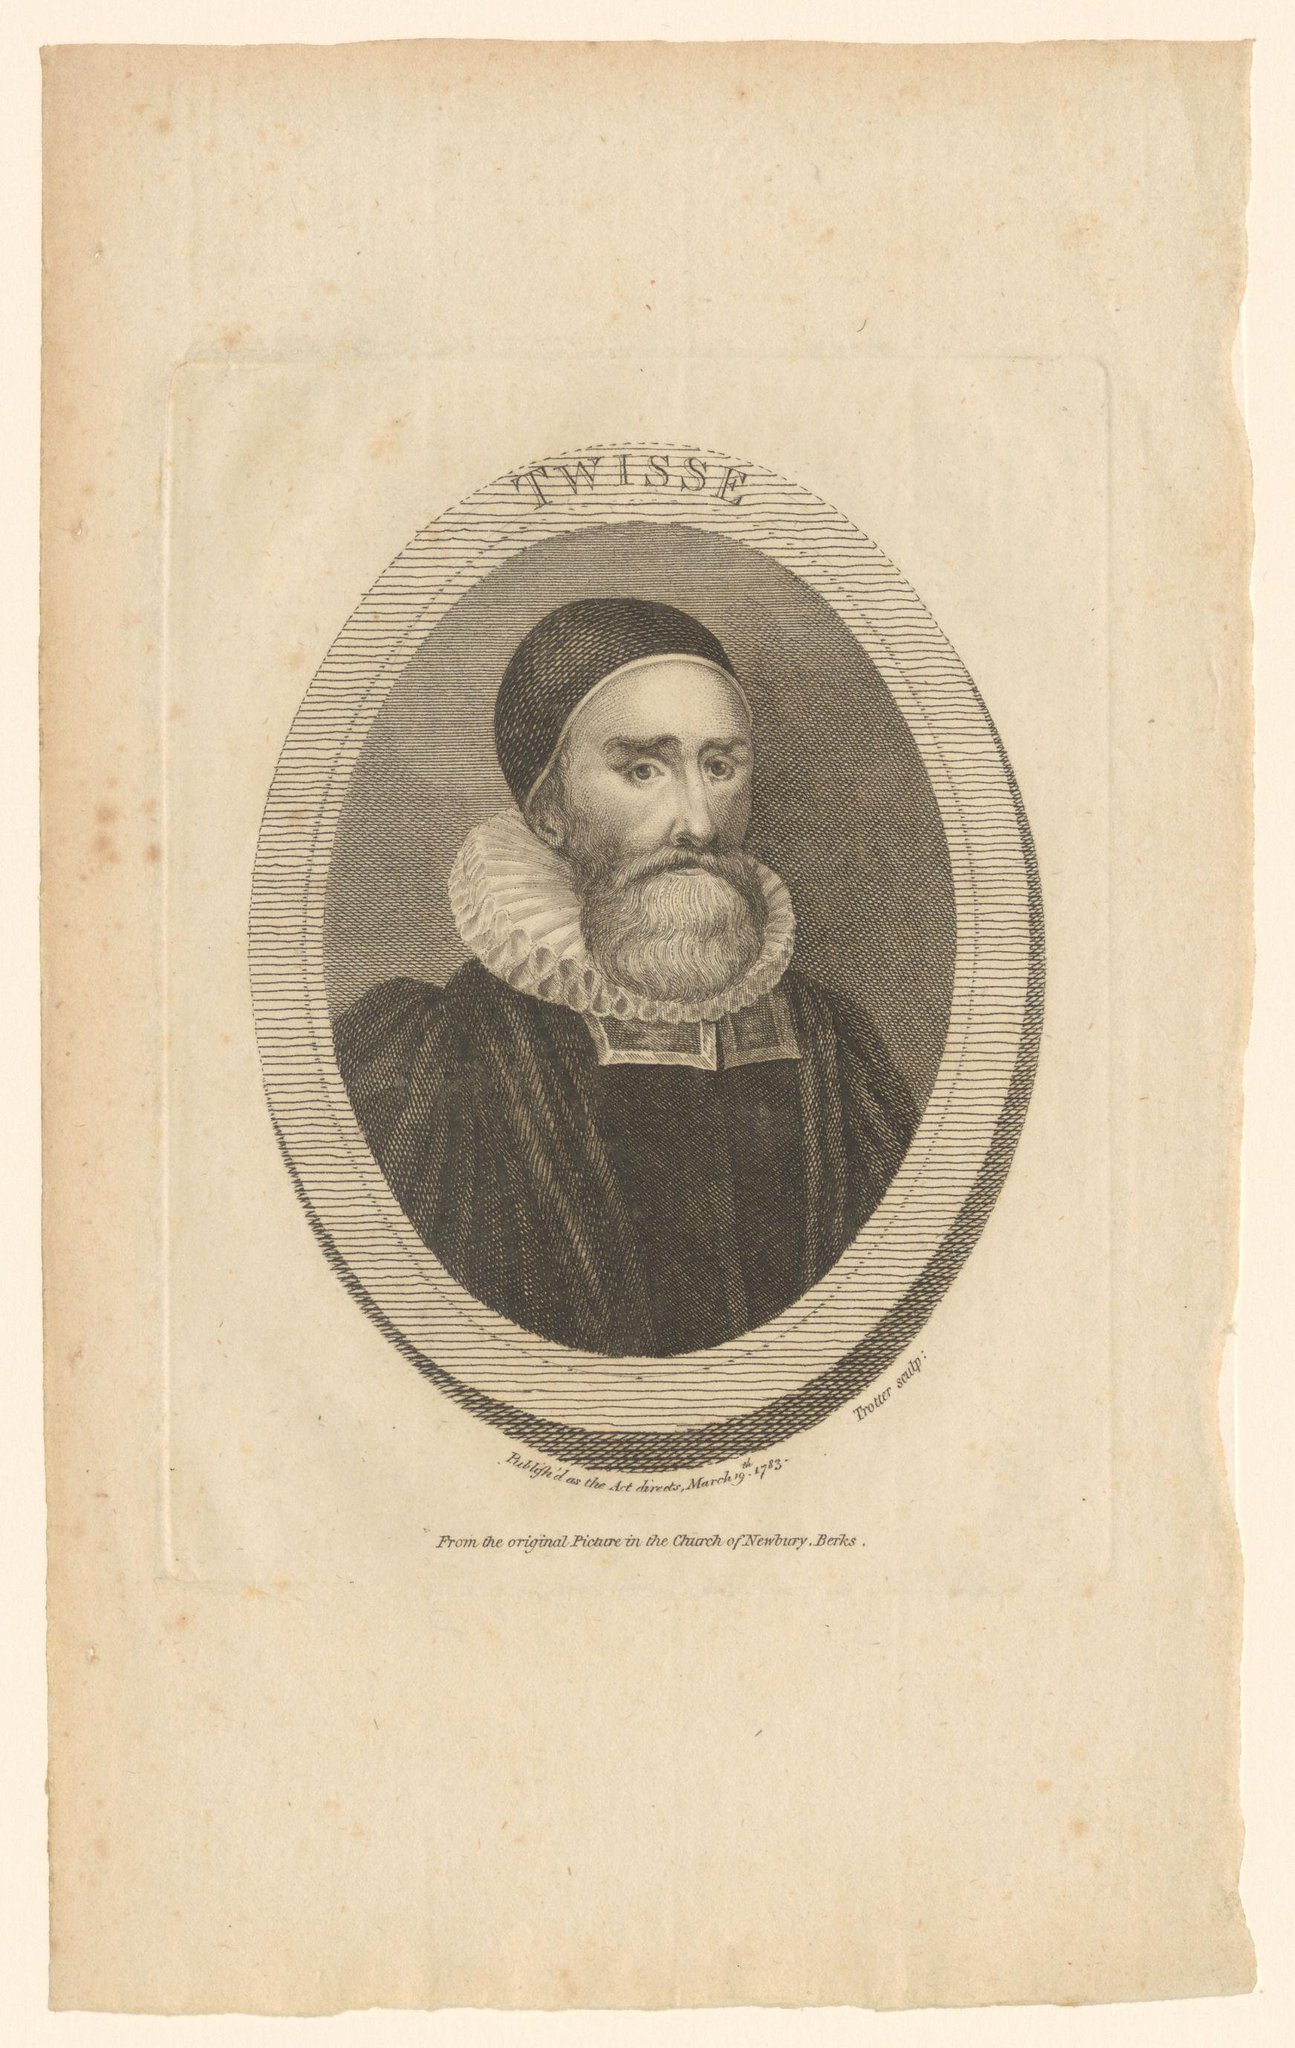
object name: book illustration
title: Twisse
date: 1703-1783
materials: paper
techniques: engraving, etching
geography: london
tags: clergyman, theologian, historical persons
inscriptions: collector's mark: Lugt 2228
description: Prent uit: Middleton, Erasmus. Biographia Evangelica (...). Londen: Alexander Hogg, 1783.